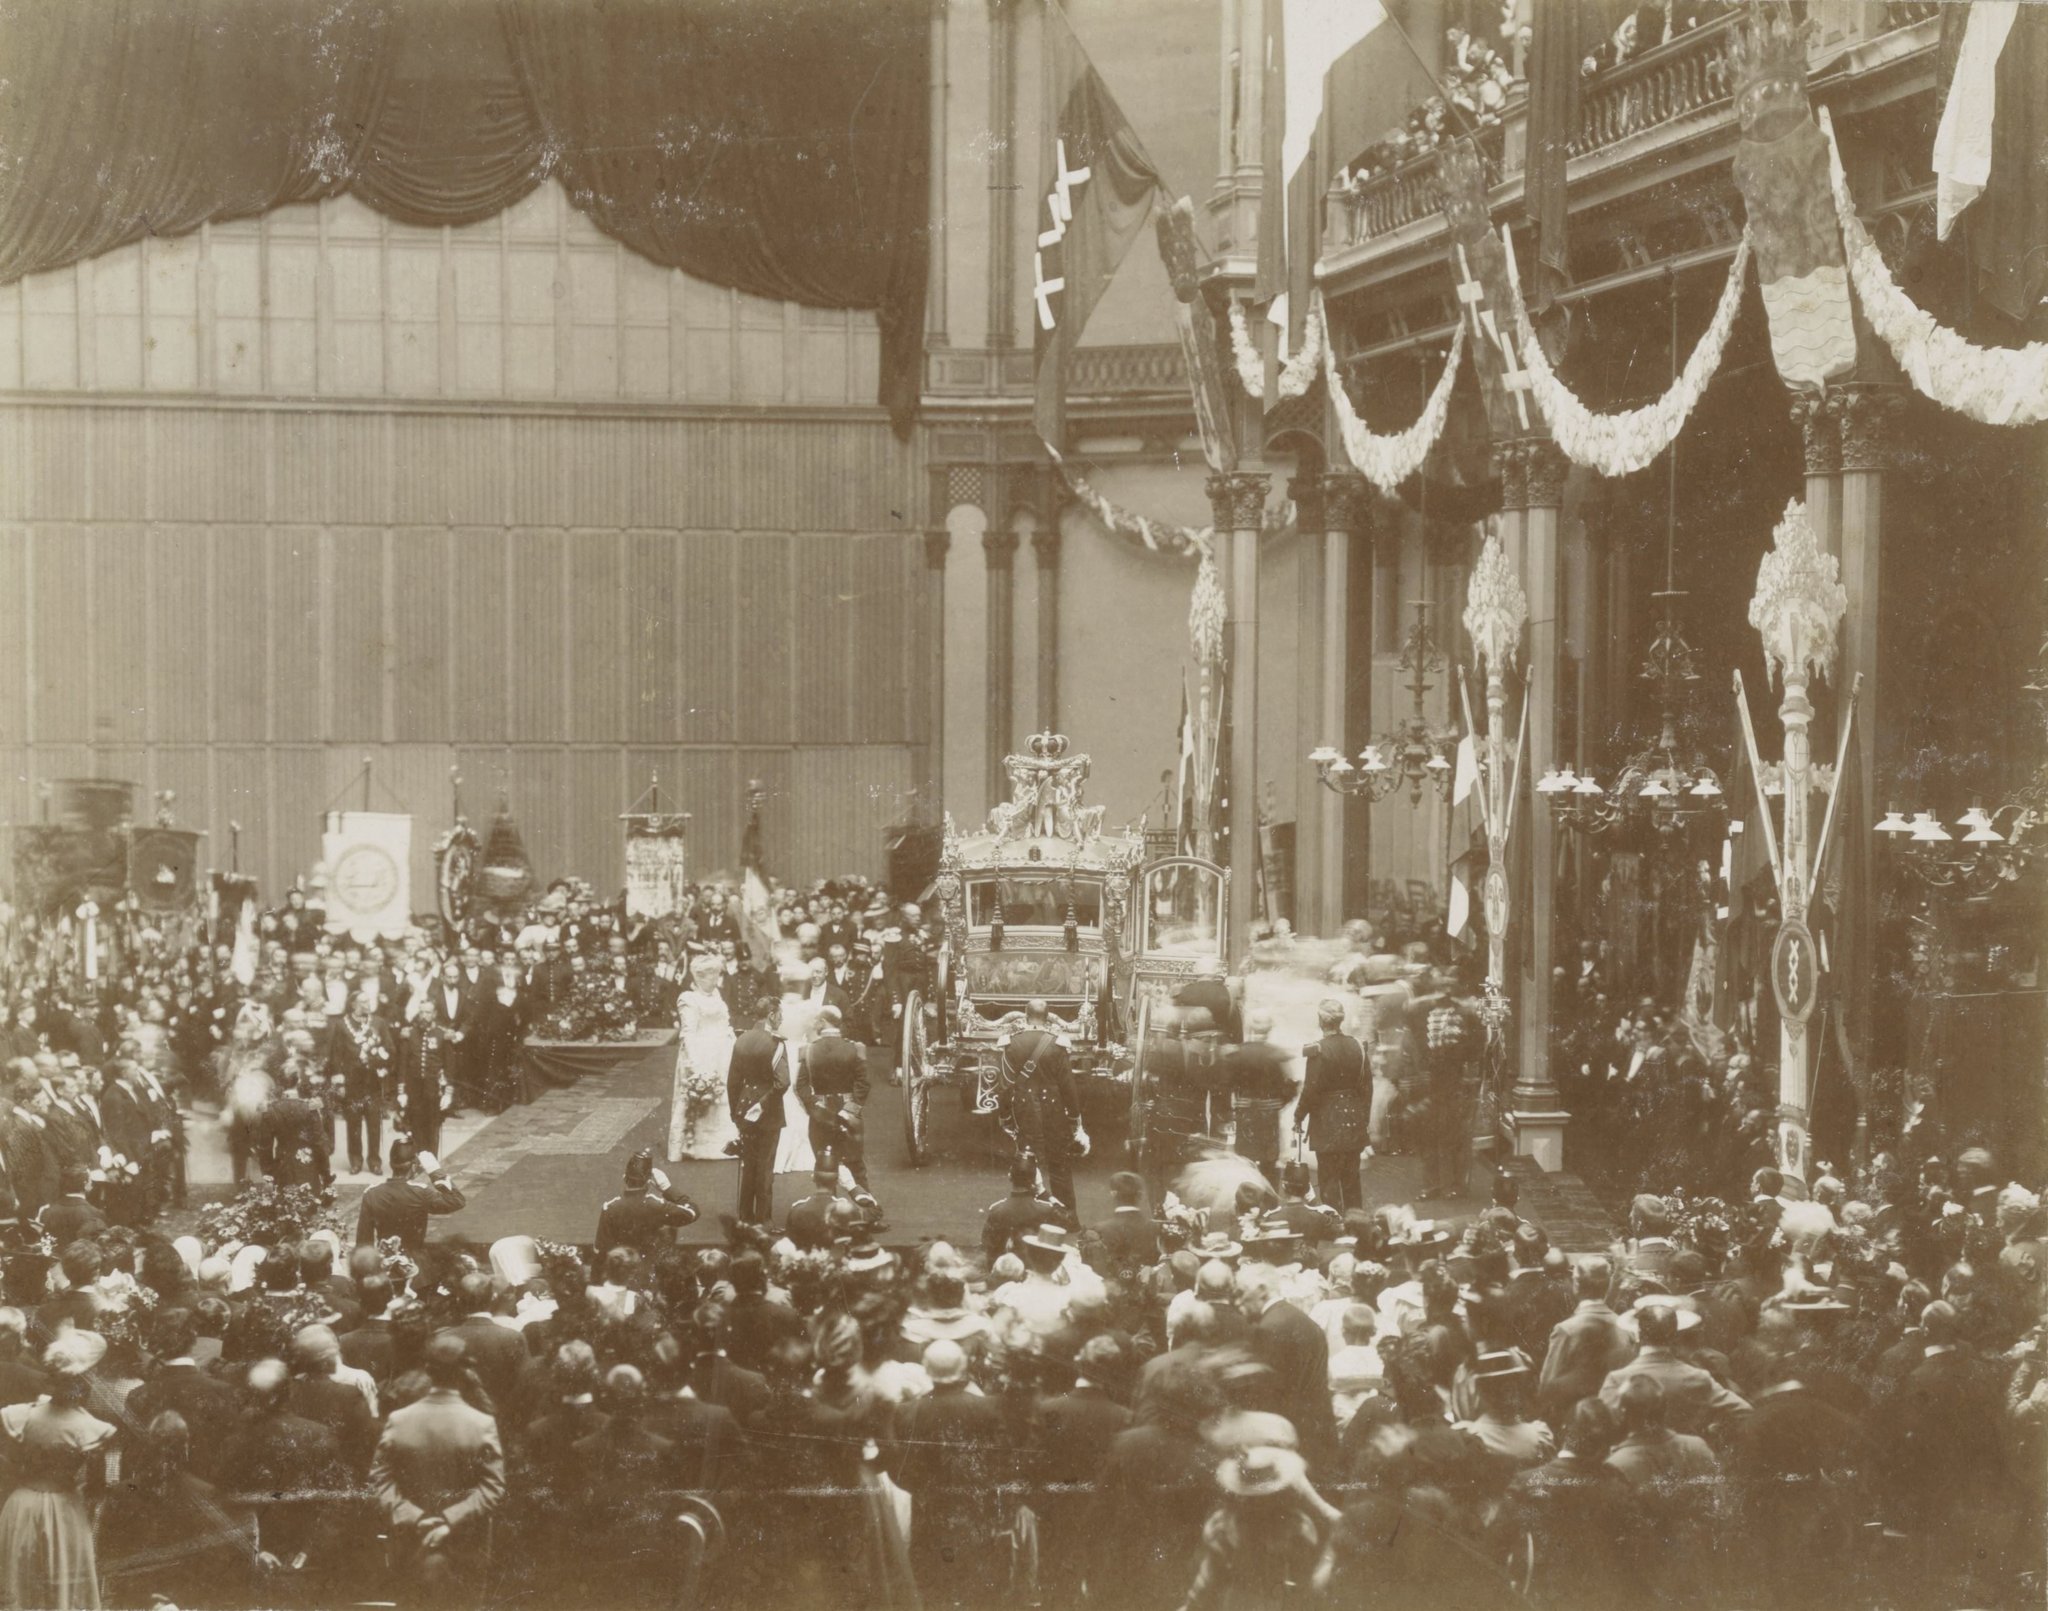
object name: photograph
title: Ingebruikneming van de Gouden Koets[onz]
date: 1898-1901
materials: cardboard, photographic support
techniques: albumen print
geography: amsterdam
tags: the hague, print maker, wilhelmina of the netherlands, amsterdam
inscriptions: name: ‘Sigling & Lukera Amsterdam Jacob van Campenstraat 96’